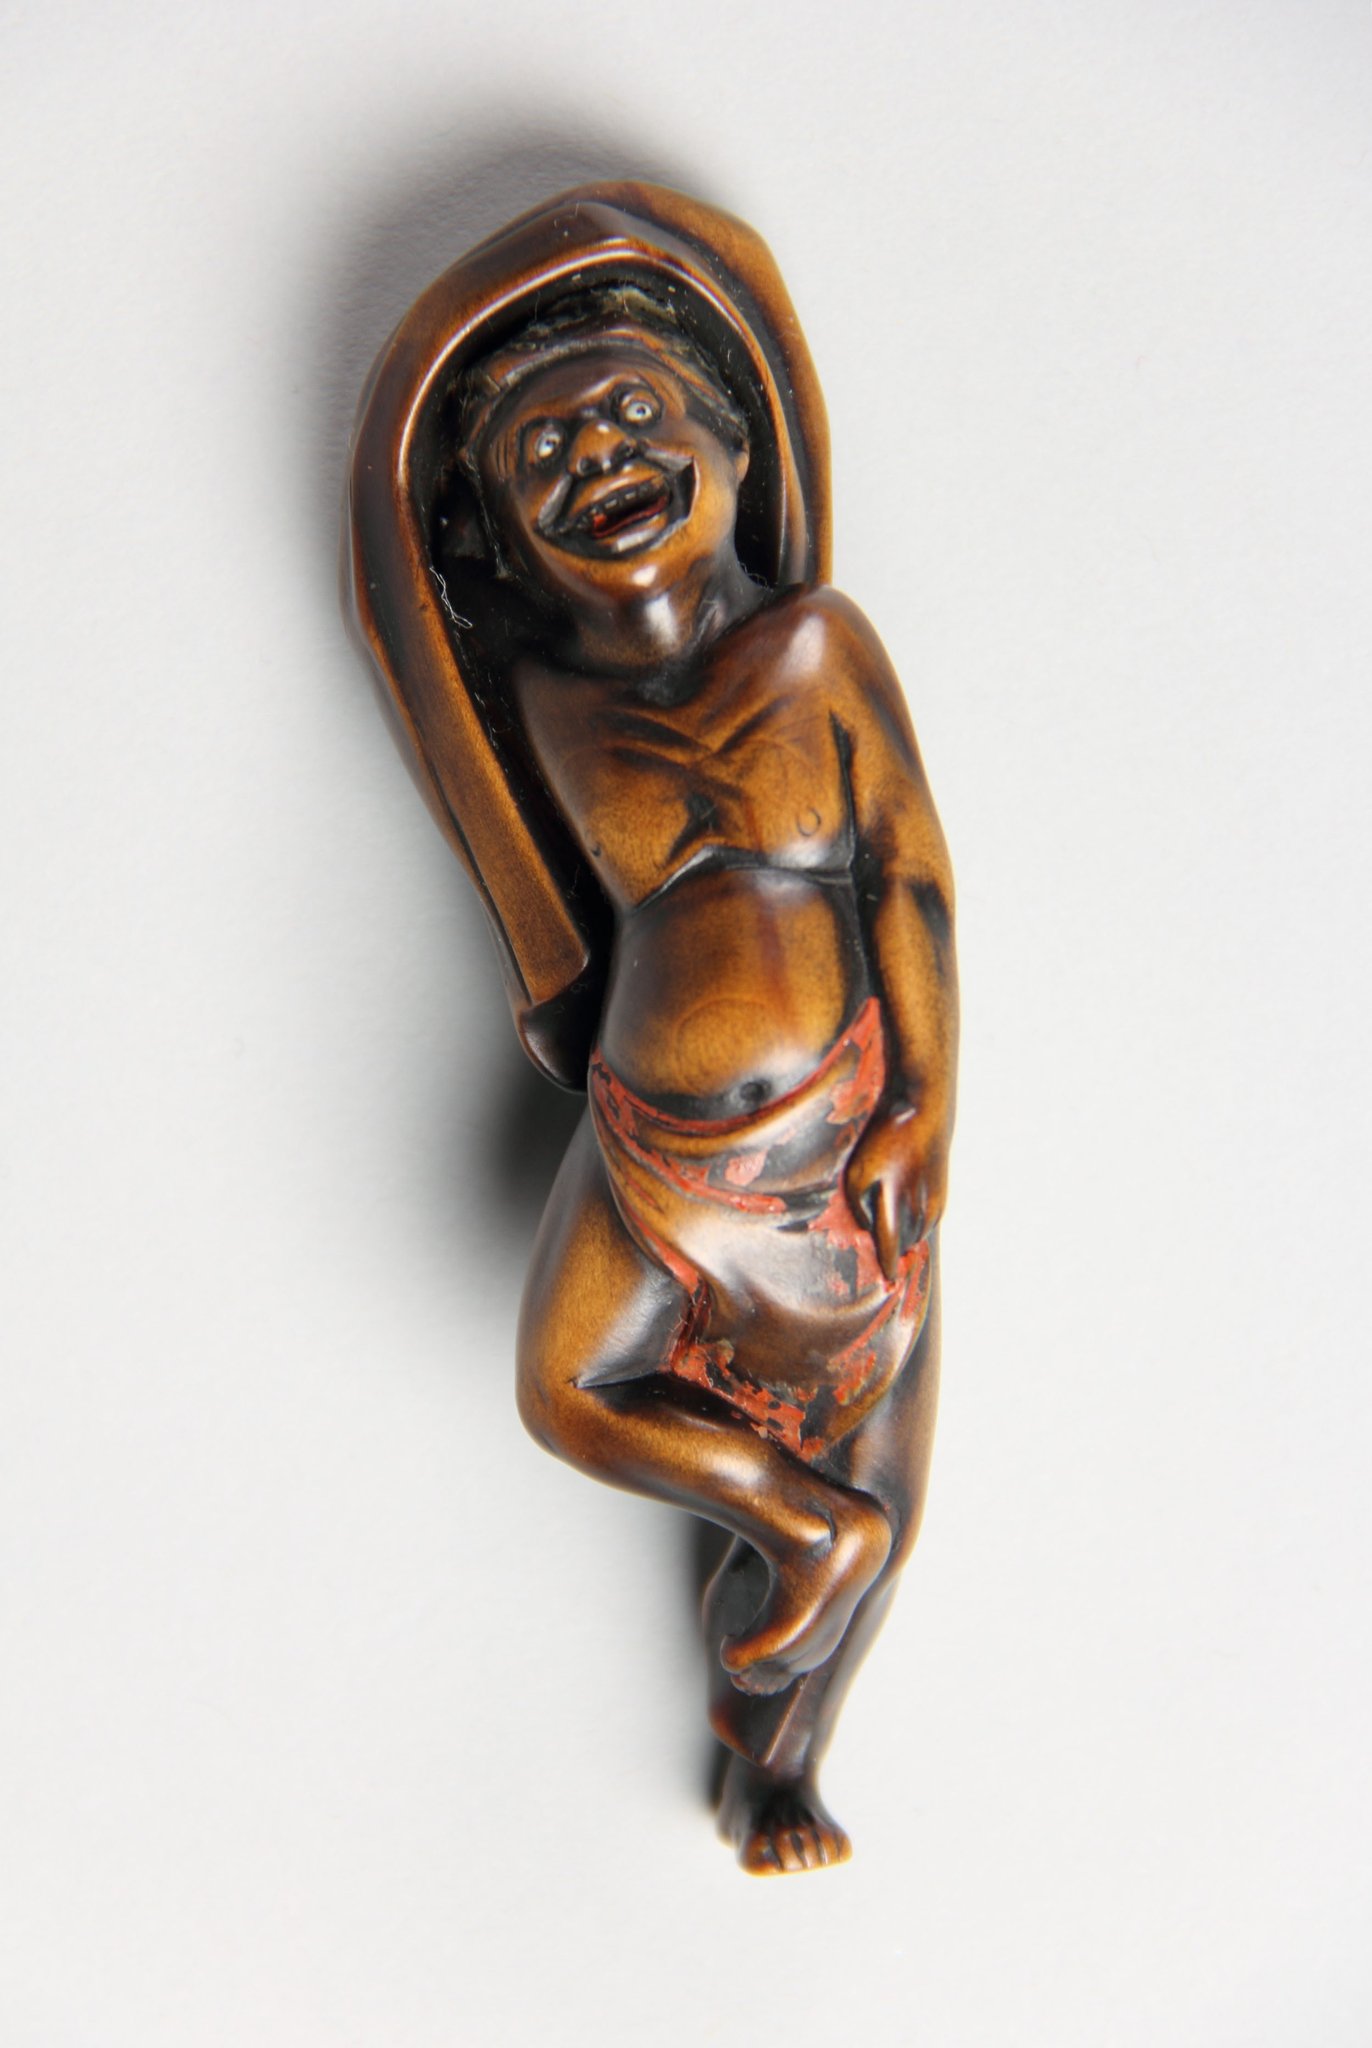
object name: netsuke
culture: japanese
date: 1801-1900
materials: wood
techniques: inlay, polychrome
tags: men